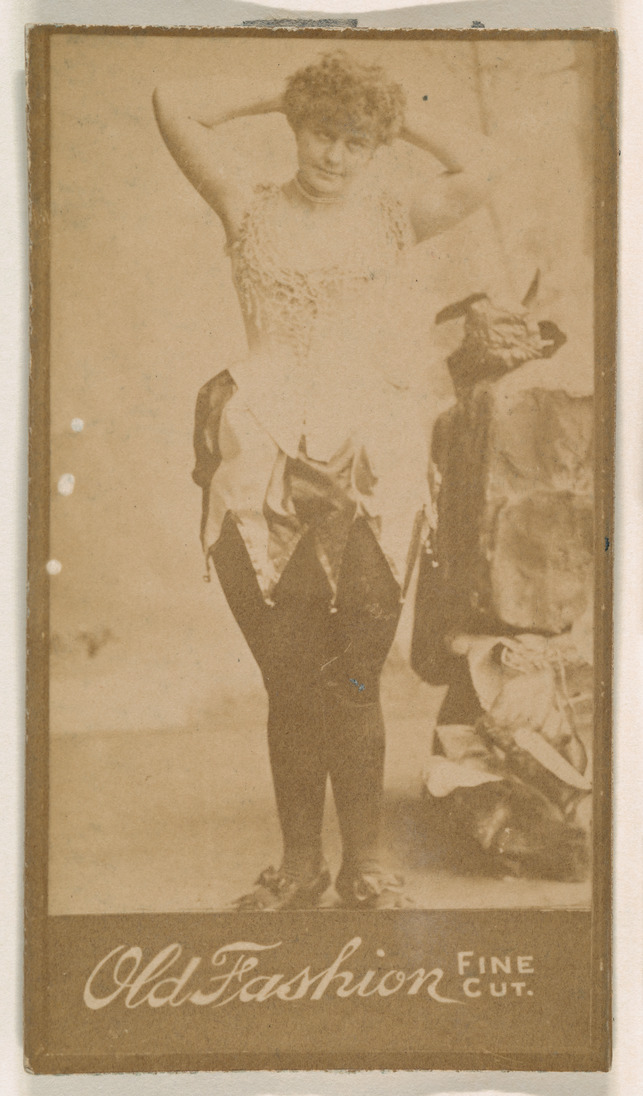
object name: photograph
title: Actress posing with hands behind head, from the Actresses series (N664) promoting Old Fashion Fine Cut Tobacco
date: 1888-1890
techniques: albumen silver print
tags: portraits,women,actresses